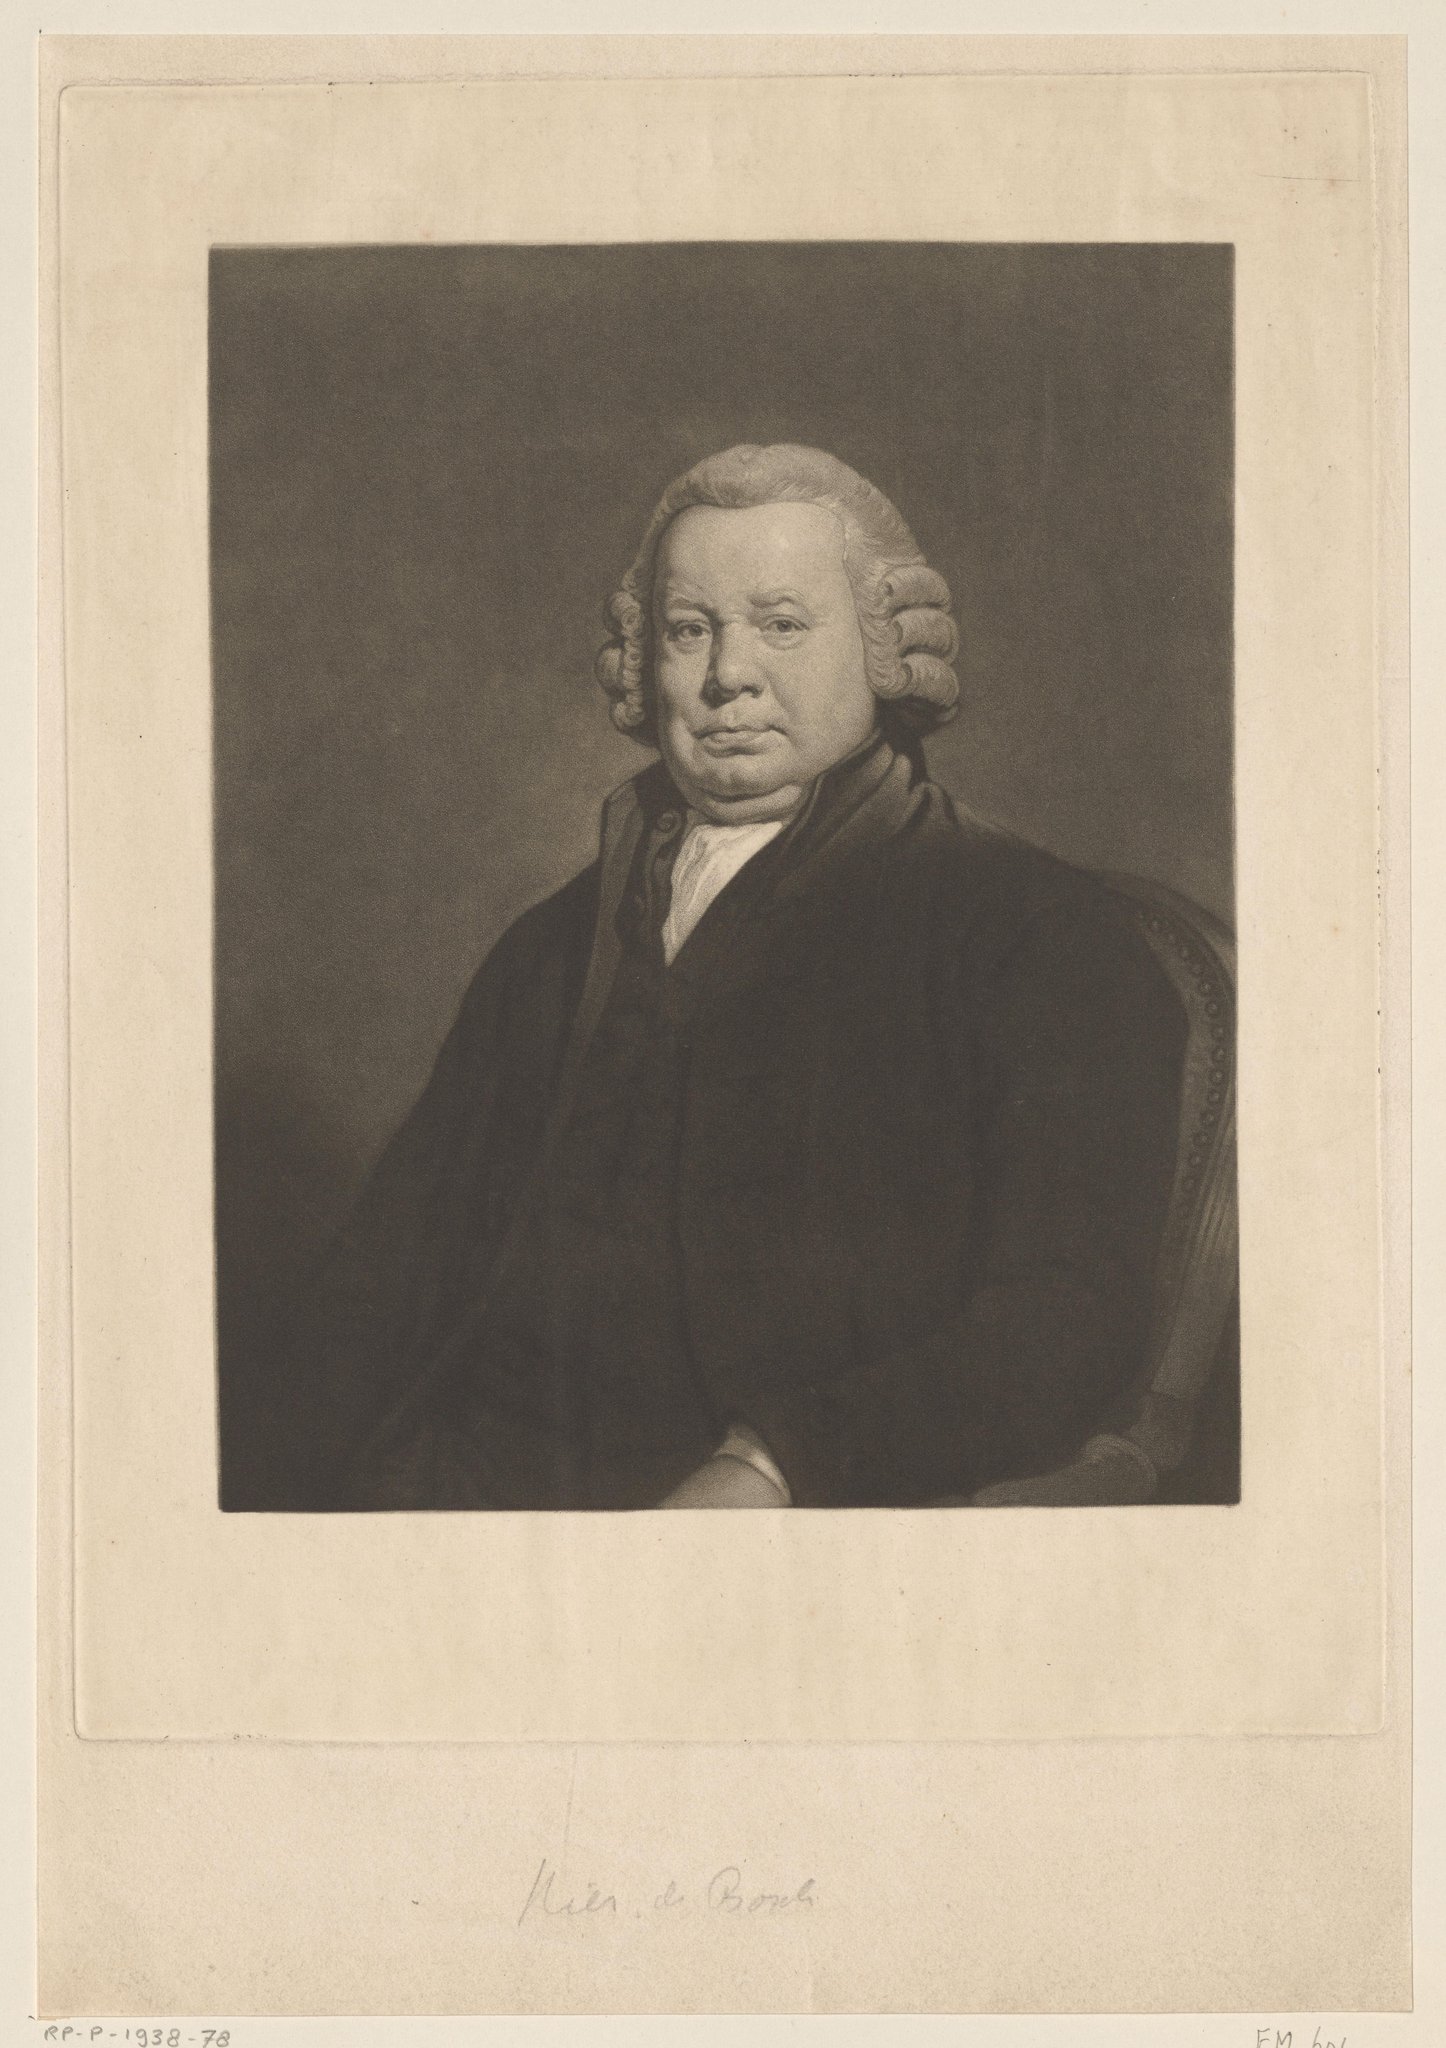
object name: print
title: Portret van Jeronimo de Bosch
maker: charles howard hodges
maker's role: draughtsman, painter, print maker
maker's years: 1764-1837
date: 1774-1837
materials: paper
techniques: mezzotint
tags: jeronimo de bosch, historical persons, writer, poet, author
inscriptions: collector's mark: Lugt 2228